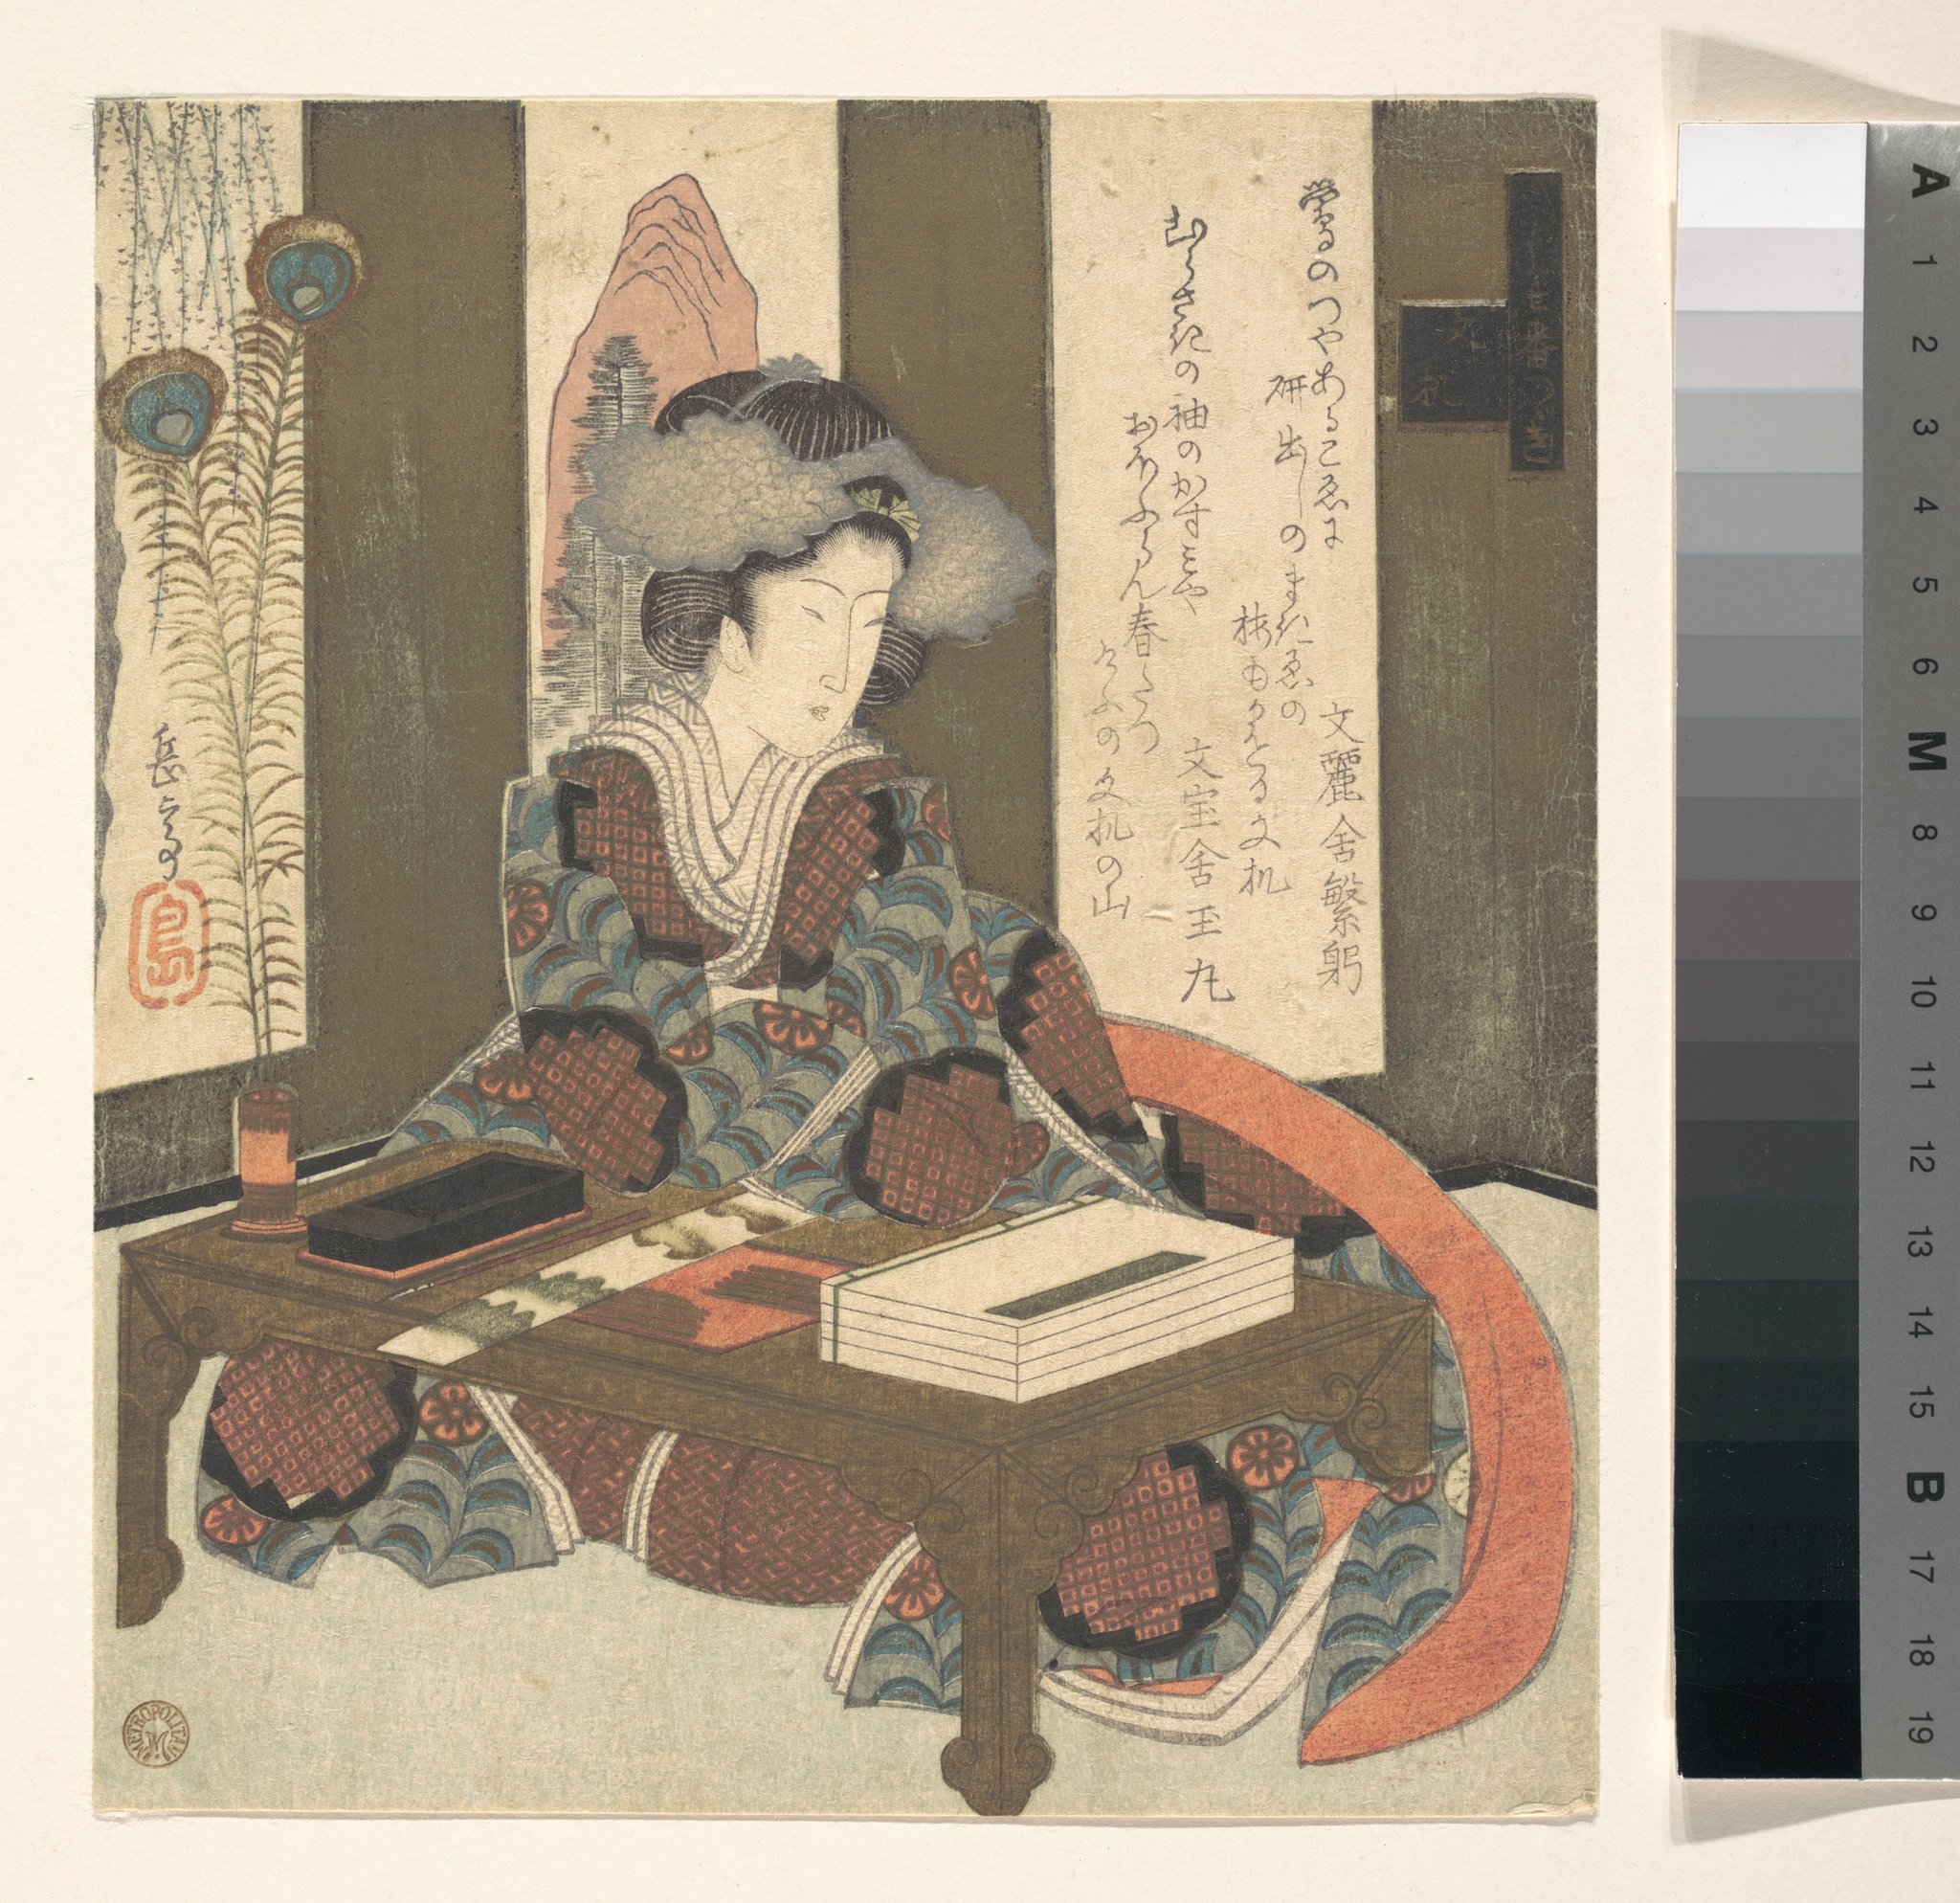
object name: print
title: A Lady About to Write a Poem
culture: japanese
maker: yashima gakutei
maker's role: artist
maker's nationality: japanese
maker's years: 1786-1868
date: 1820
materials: ink, paper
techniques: surimono, woodblock print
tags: poetry,women,writing,desks